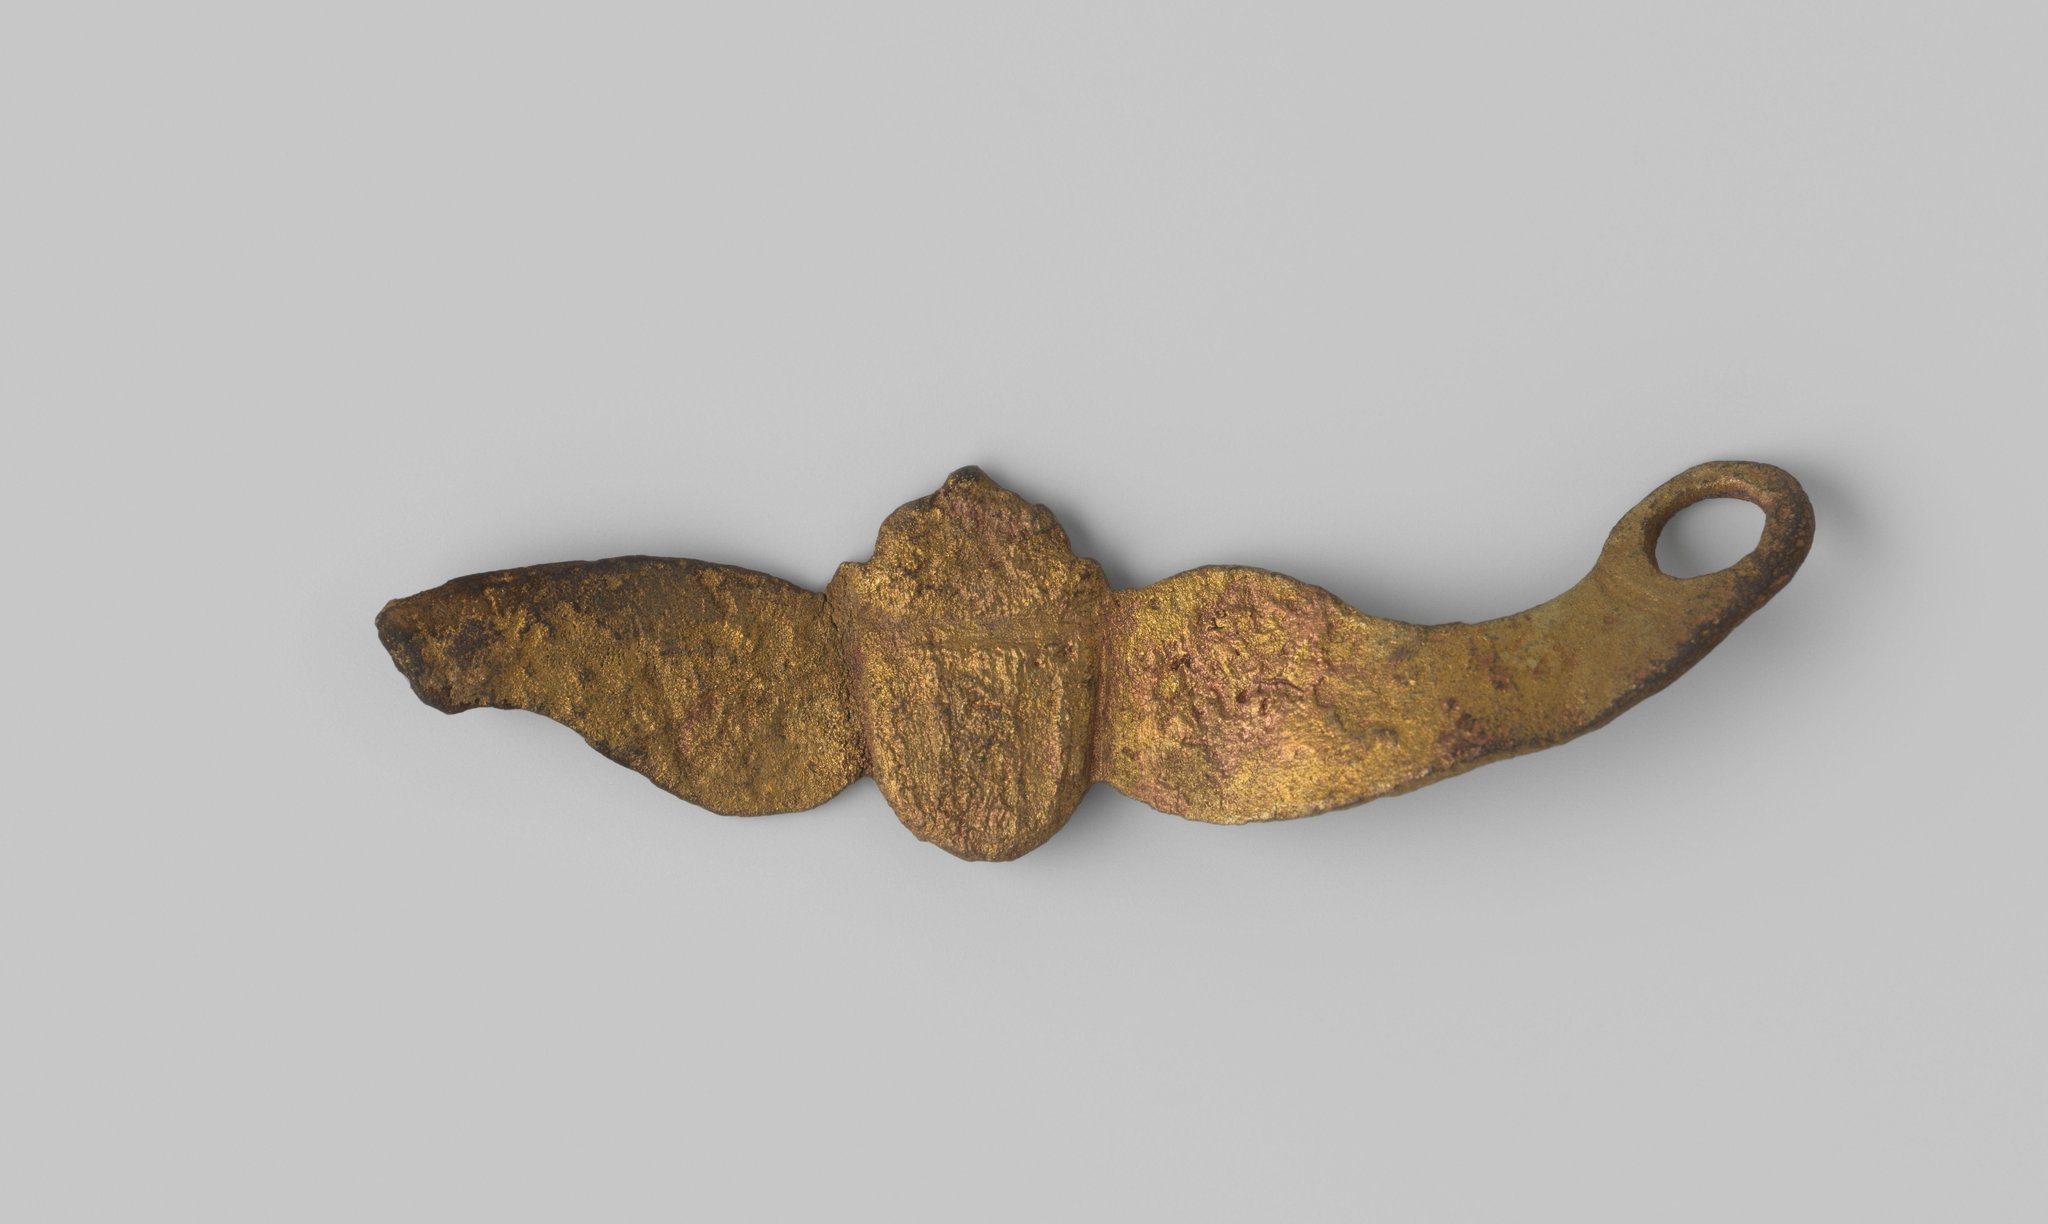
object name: musket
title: Fragment schroefplaat van een musket uit het wrak van de Oost-Indiëvaarder Hollandia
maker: Anonymous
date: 1700-1743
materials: copper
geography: netherlands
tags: verenigde oostindische compagnie, hollandia (schip), annet